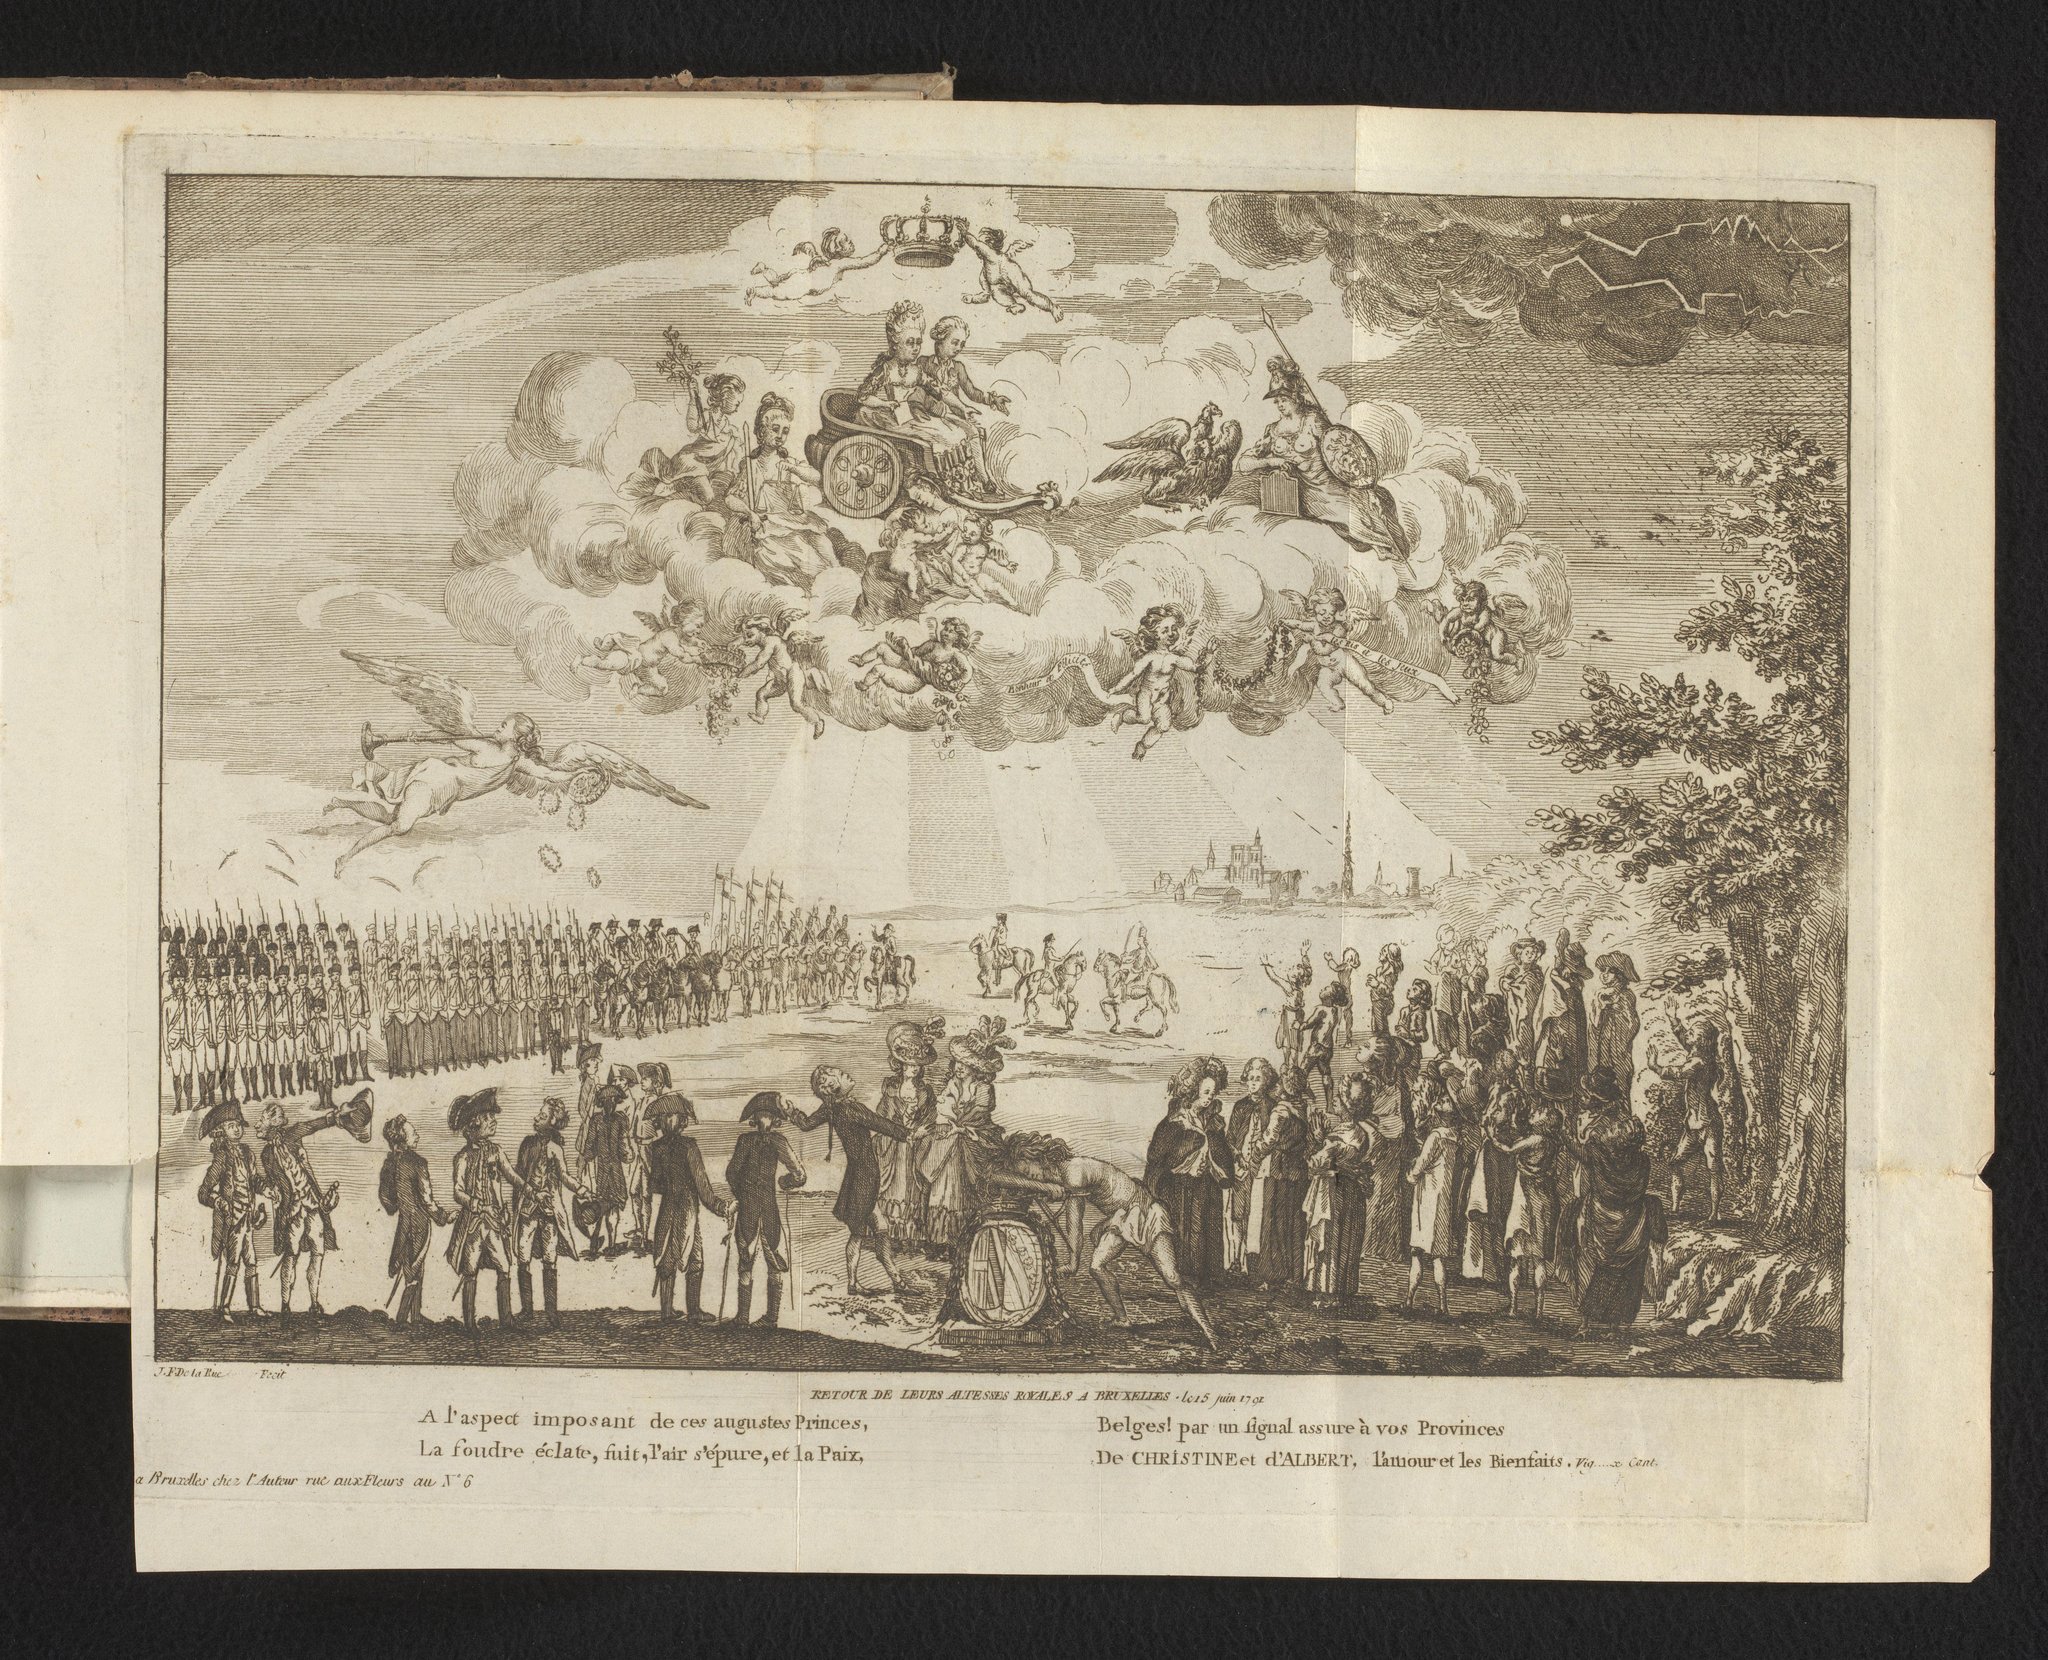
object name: print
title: Retour de leurs altesses royales a Bruxelles, le 15 juin 1791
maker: j.f. de la rue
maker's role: print maker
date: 1791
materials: paper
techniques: engraving, etching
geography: brussels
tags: albert casimir van saksen-teschen, vienna, maria christina van oostenrijk (1742-1798), symbolic triumphs of individual persons, brabant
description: Allegorische voorstelling van de terugkeer van Albert Casimir en zijn echtgenote Maria Christine, landvoogden van de Oostenrijkse Nederlanden op 15 juni 1791. Het paar in een triomfwagen getrokken door adelaars in de wolken, omgeven door engelen. Op de grond kijken het verzamelde volk en opstelde militairen toe. Met vierregelig Frans vers. Onderdeel van de gebundelde verzameling prenten betrekking hebbend op de gebeurtenissen van de Brabantse Omwenteling en de periode 1787-1790.